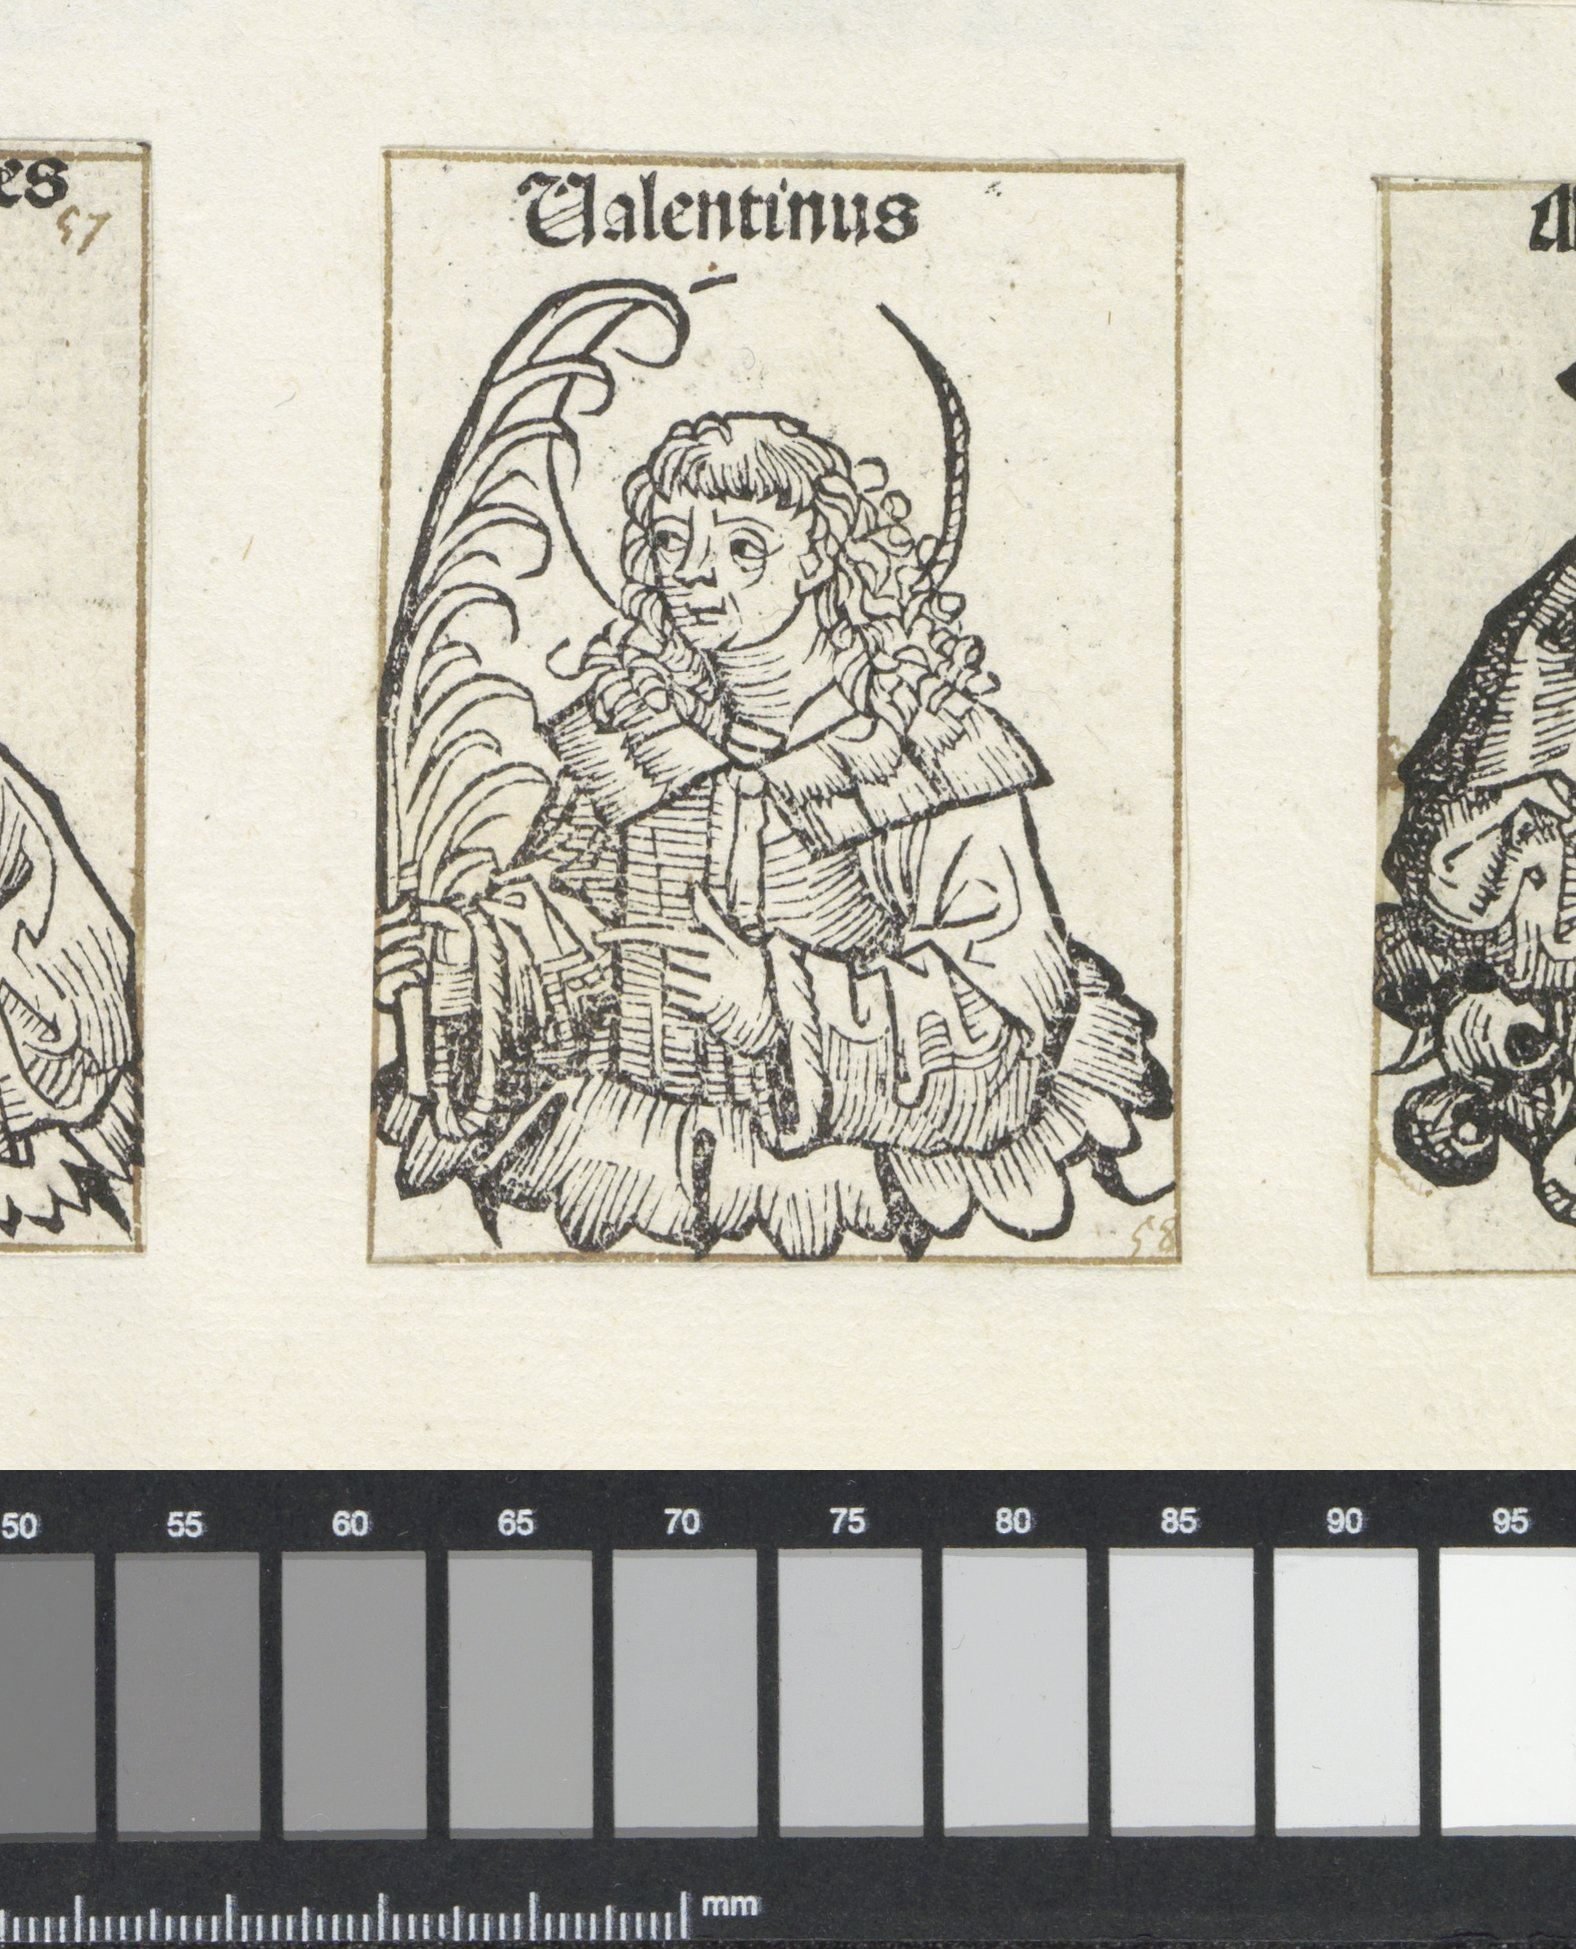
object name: print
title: Valentinus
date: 1493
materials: paper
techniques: letterpress printing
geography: nuremberg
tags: saints, martyr(s) (often with palm-branches)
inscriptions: inscription: ‘58’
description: De houtsnede wordt herhaaldelijk gebruikt als boekillustratie in de Liber Chronicarum (of Neurenbergkroniek) van Hartmann Schedel, verschenen in het Latijn en Duits in 1493. Zie de Latijnse uitgave, folio 122r.